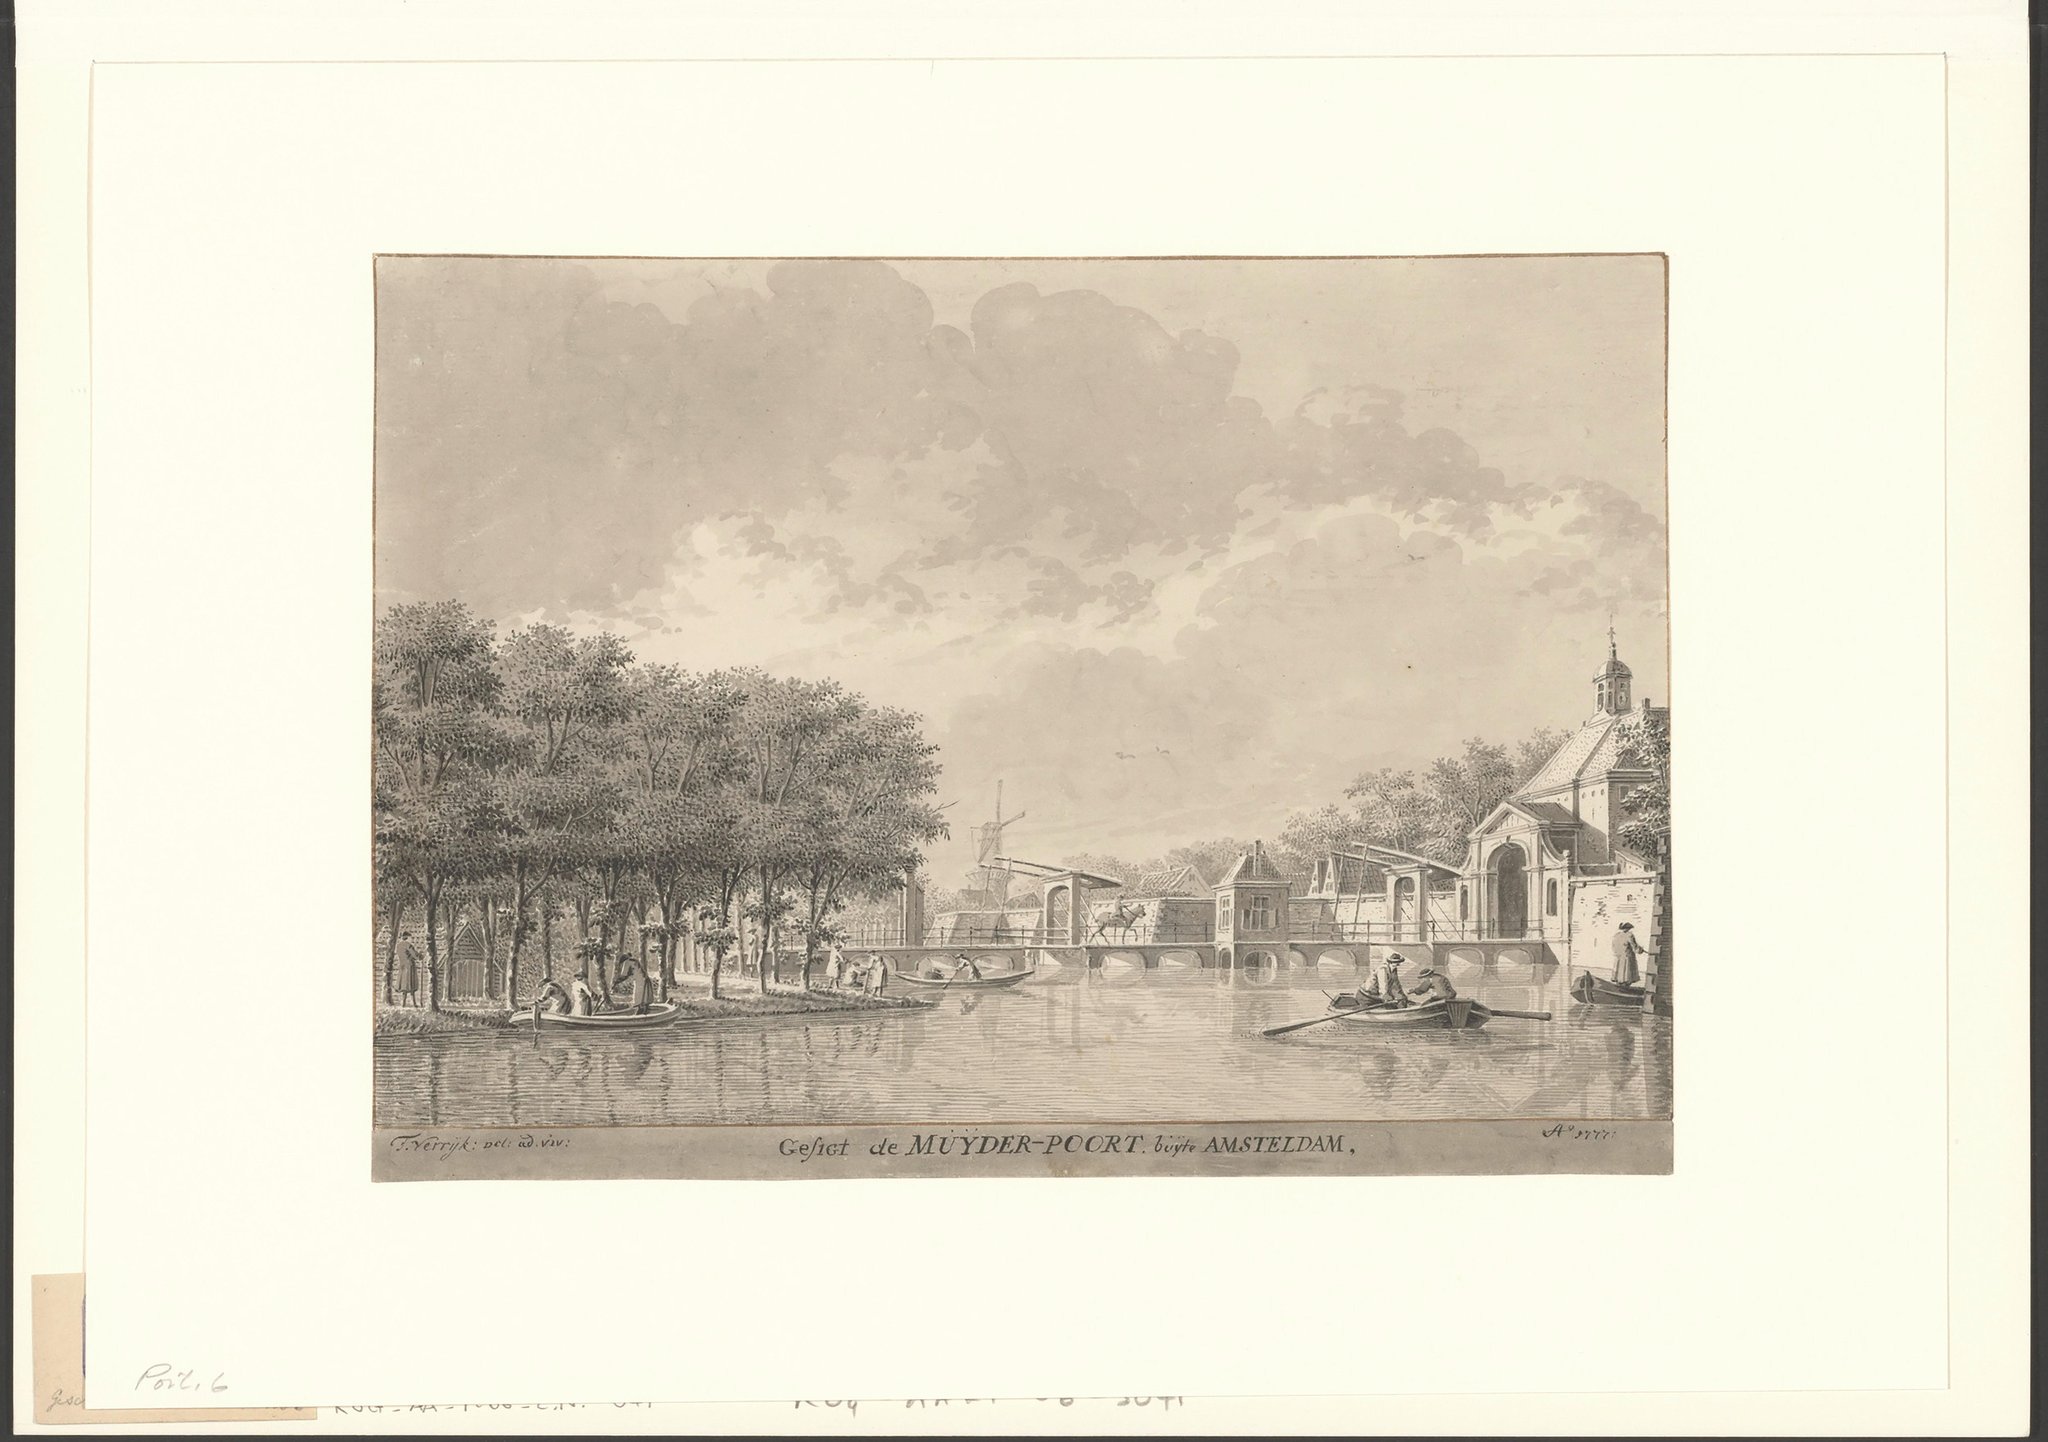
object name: drawing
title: Gezicht op de eerste Muiderpoort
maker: dirk verrijk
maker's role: draughtsman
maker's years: 1734-1786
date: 1777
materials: ink, paper, pencil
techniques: brush, pen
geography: amsterdam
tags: city-view in general; 'veduta', river, windmill in landscape, bridge in city across river, canal, etc., city-gate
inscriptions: inscription: ‘de Muy[...]poort’, signature and date: ‘T.Verrijk:del:ad.viv: / Ao 1777’, inscription: ‘Port. 6’, inscription: ‘Geschenk v/d Heer Koch 1882’, collector's mark: ‘6’ Lugt 1641b, inscription: ‘Gesigt de Muyder-Poort buyte Amsteldam,’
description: Onderwerpsrubriek binnen de Atlas Amsterdam: Buitensingel, Gezichten langs en op de Stadsvest van Raampoort tot Zeeburgerdijk.